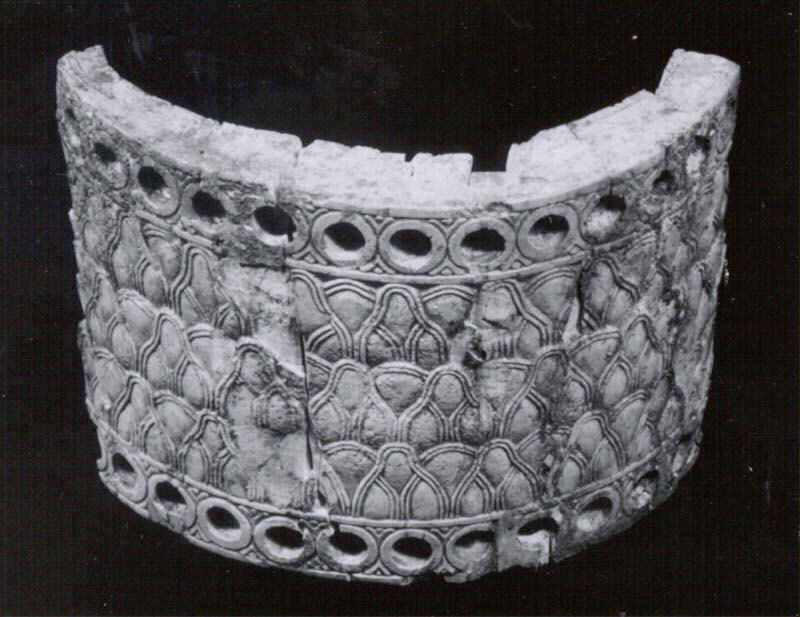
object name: relief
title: Patterned frieze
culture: assyrian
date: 800-701 BCE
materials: ivory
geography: mesopotamia